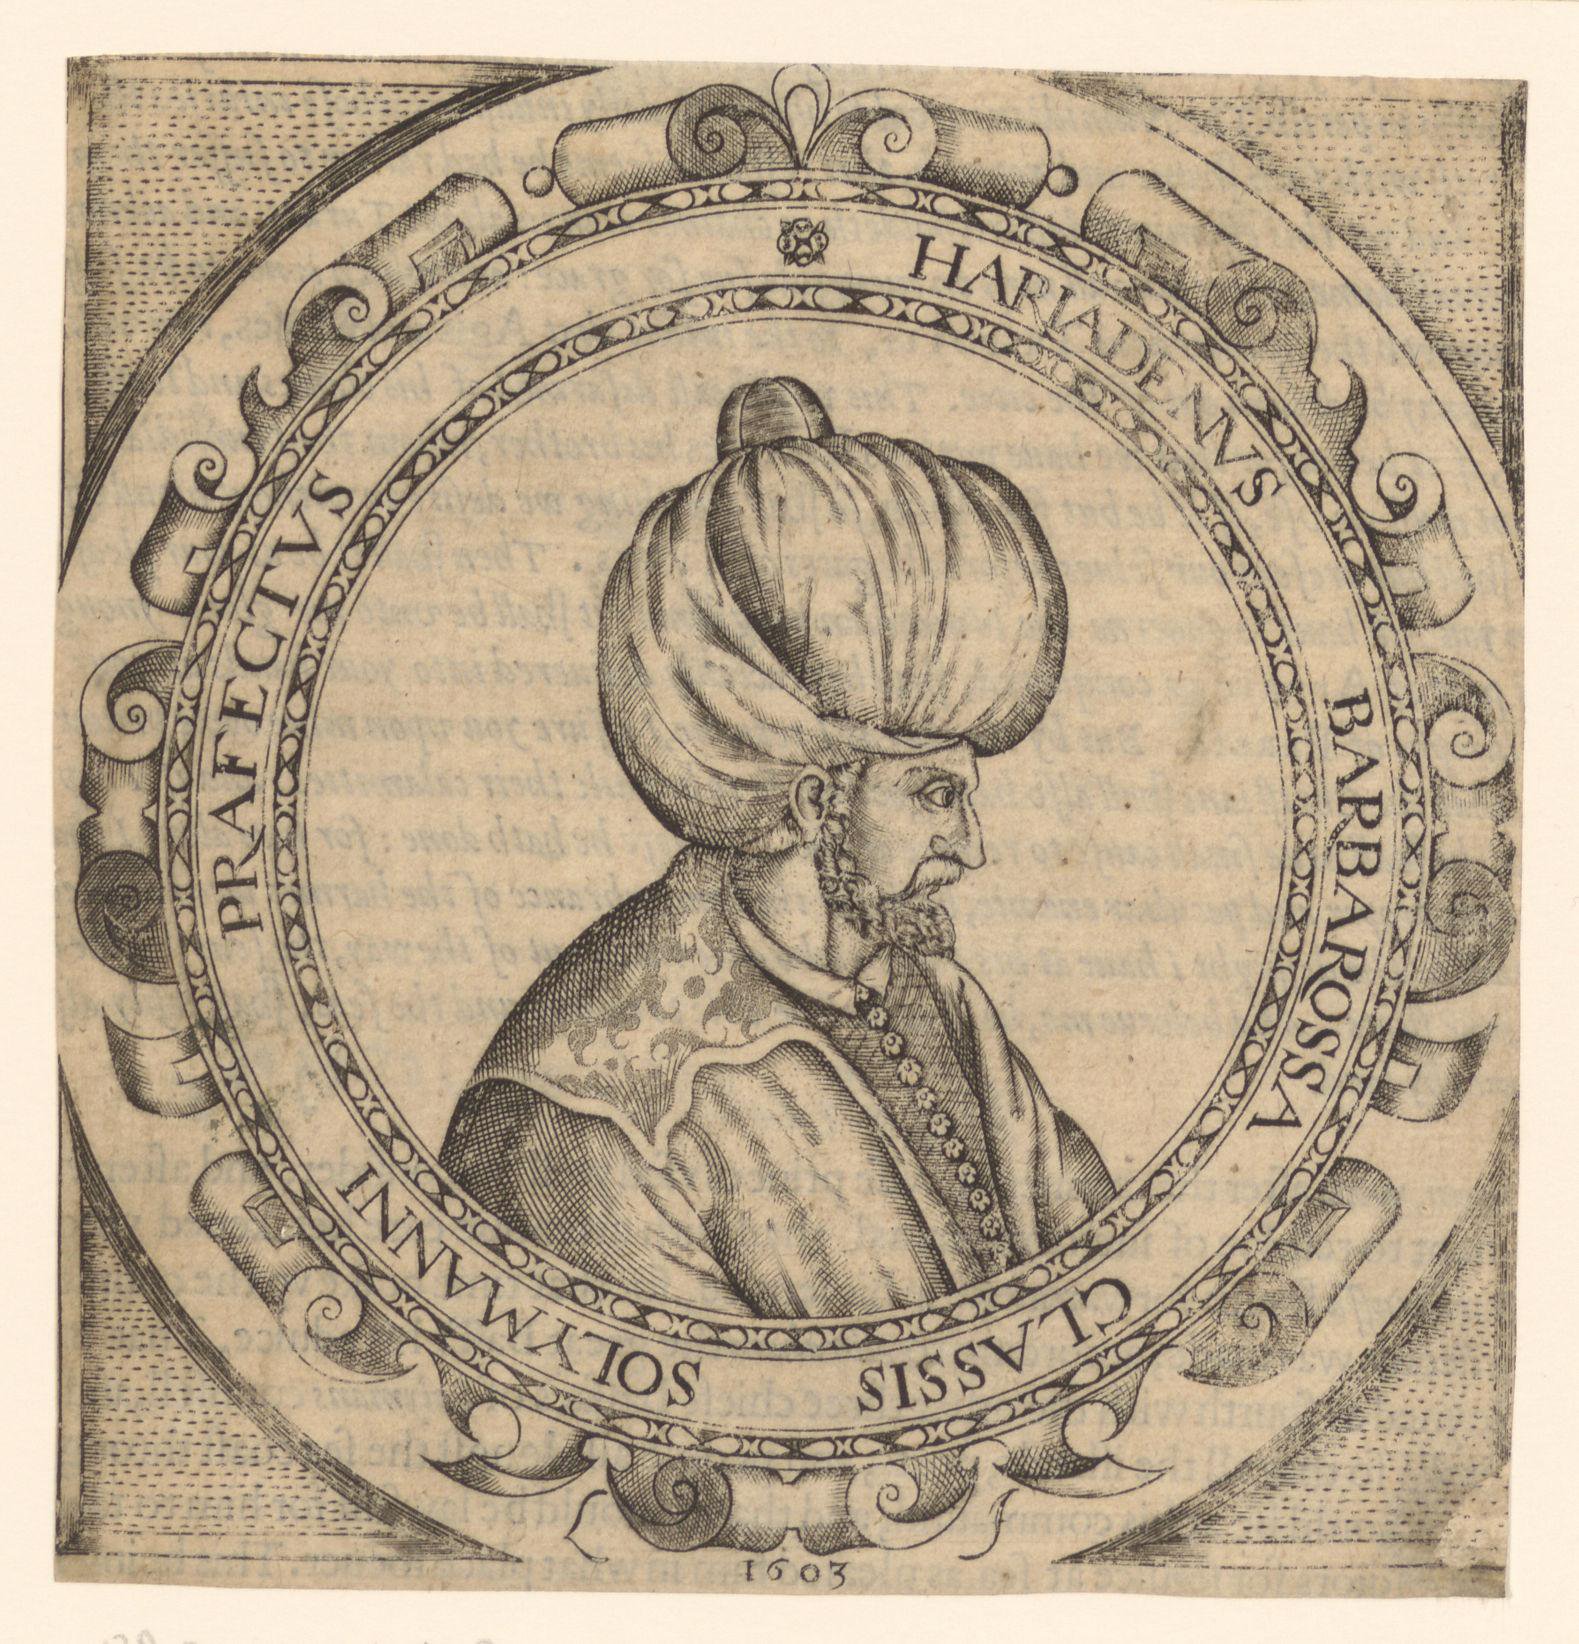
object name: print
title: Portret van Khair ad-Din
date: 1603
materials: paper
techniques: engraving, letterpress printing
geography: london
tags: capuche, historical persons, ruler, sovereign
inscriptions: collector's mark: Lugt 2228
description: Prent gebruikt in: Knolles, Richard. The lives of the Othoman Kings and Emperors (...). Londen: Adam Islip, 1603. Prent ook gebruikt in: Knolles, Richard. The Generall Historie of the Turkes from the First Beginning of that Nation to the Rising of the Othoman Familie. Londen: Adam Islip, 1603.